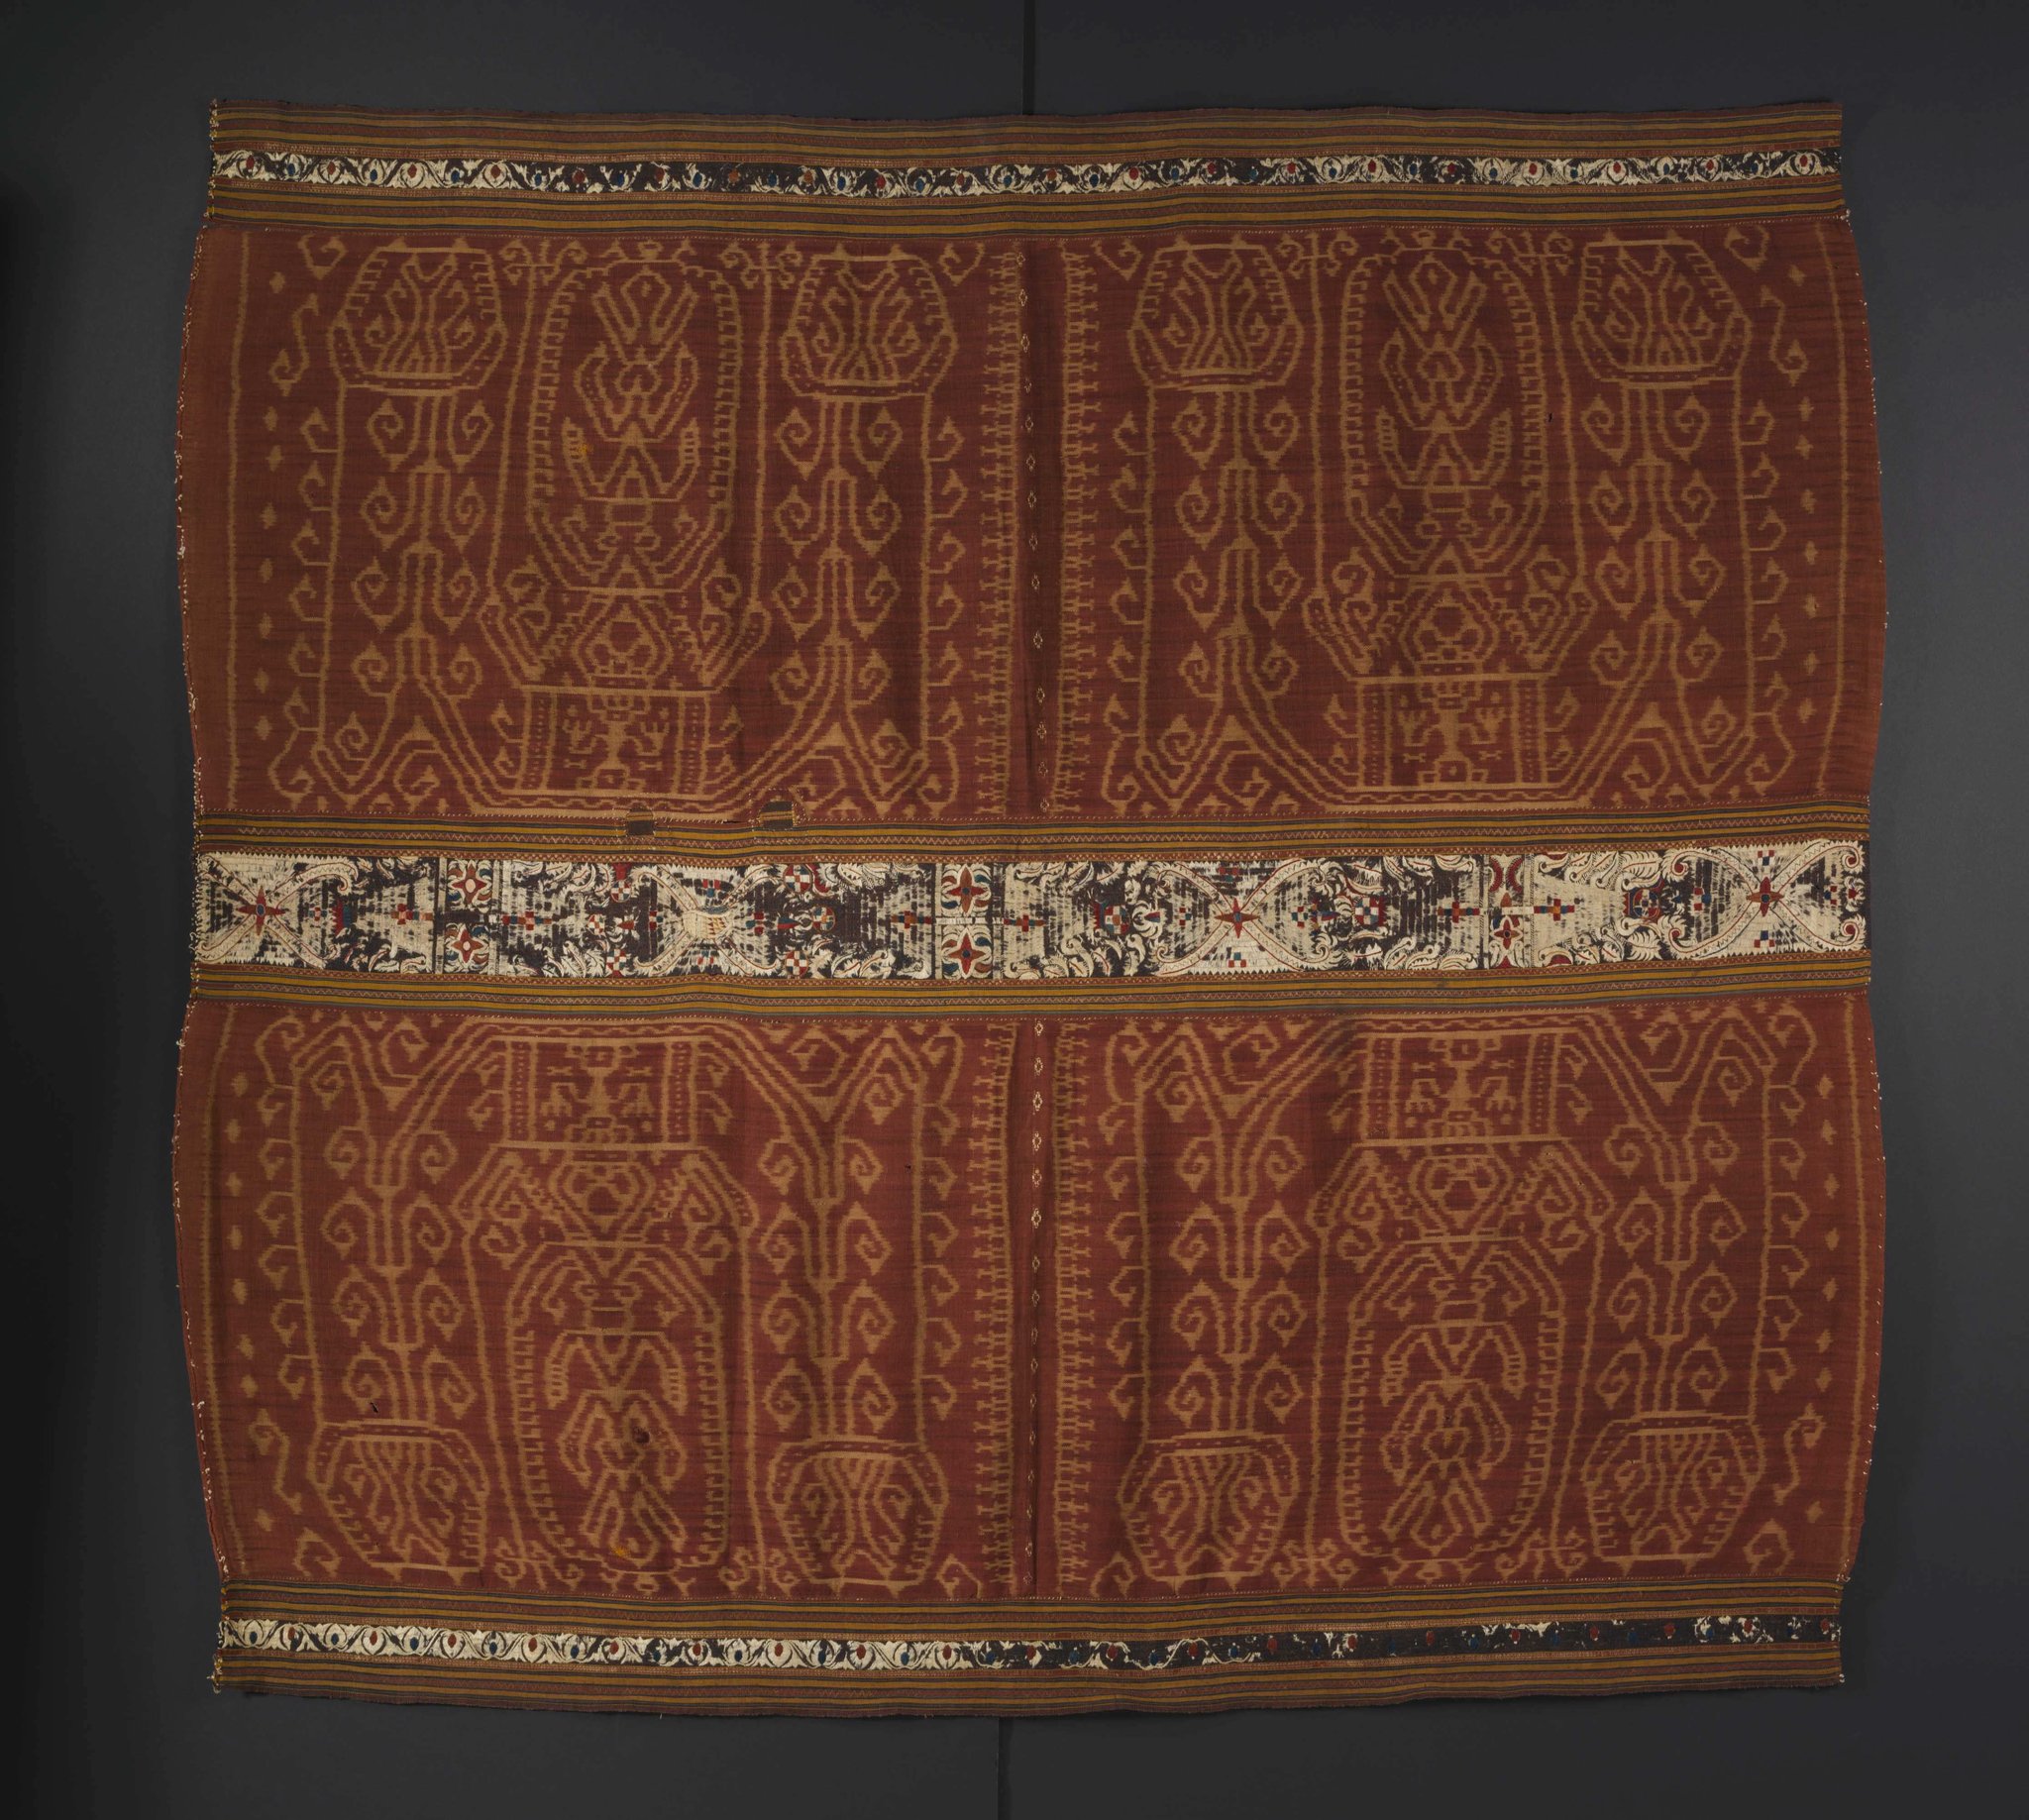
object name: skirt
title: Woman's Ceremonial Skirt (Tapis)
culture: lampung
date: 1701-1800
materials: cotton, silk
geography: indonesia